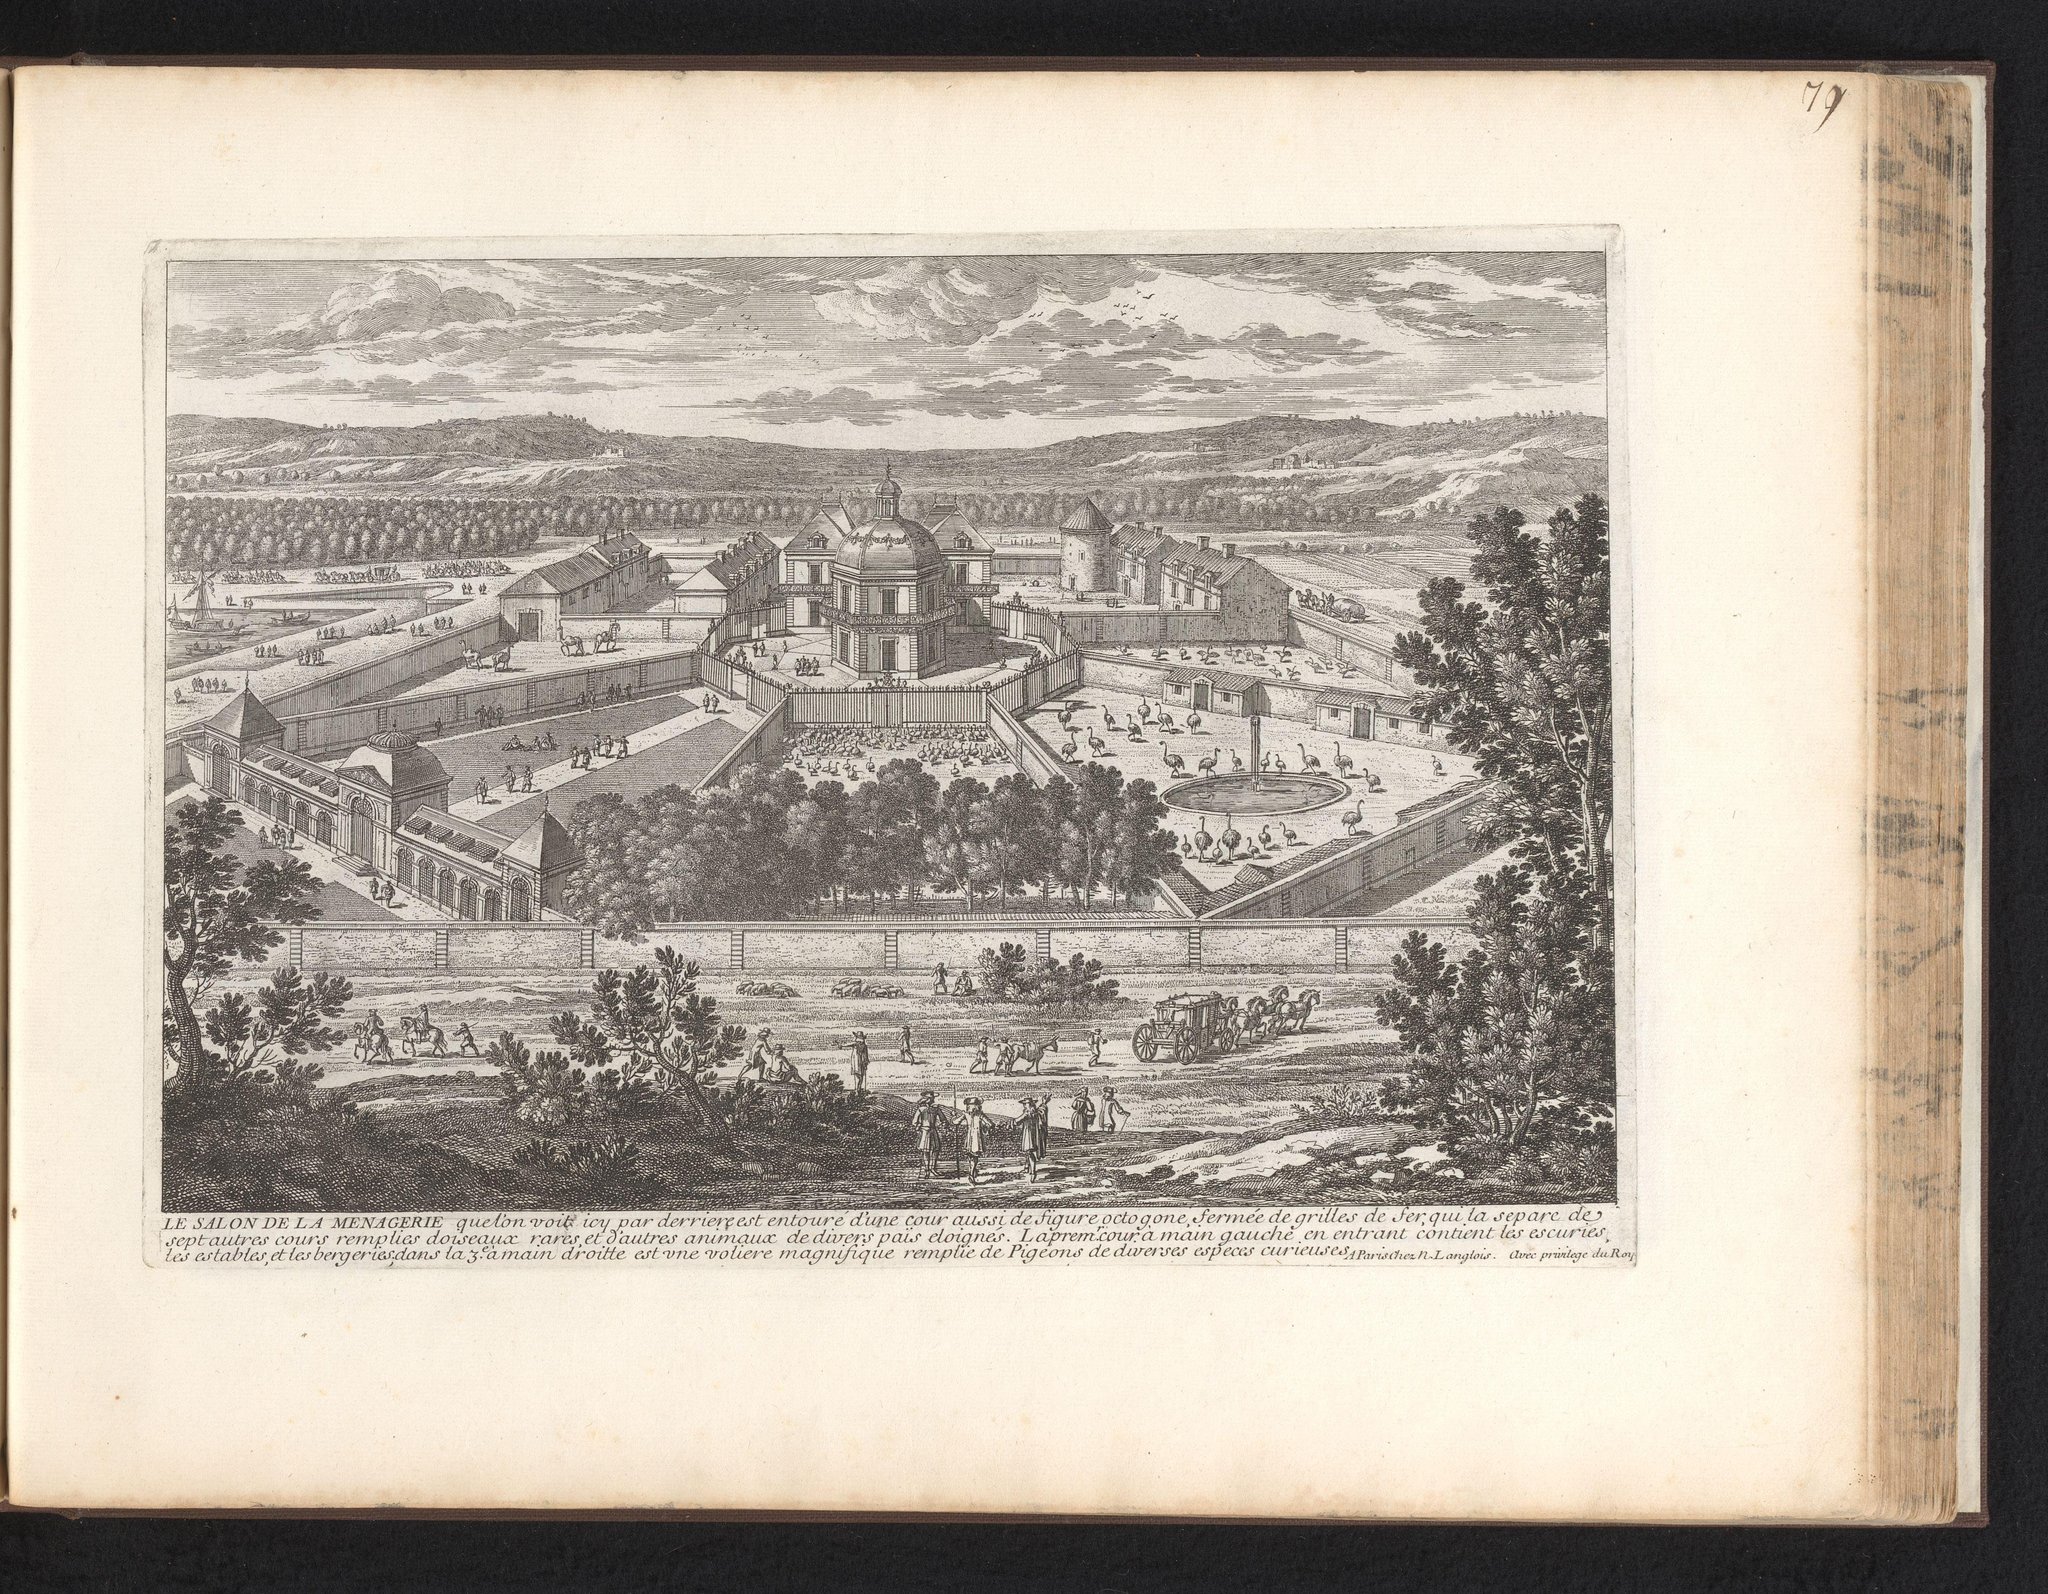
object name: album leaf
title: Gezicht op de menagerie van Versailles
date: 1664-1703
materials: paper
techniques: etching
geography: france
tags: garden fountain, french or architectonic garden; formal garden, zoological garden, zoo, seen as place where non-domestic animals are kept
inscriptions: collector's mark: Lugt 2228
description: Prenten met het signatuur 'Perelle' kunnen zowel door vader Gabriel als door zonen Nicolas en Adam gemaakt zijn. De uitgevers vader en zoon Nicolas Langlois worden allebei vermeld als N. Langlois op hetzelfde adres.